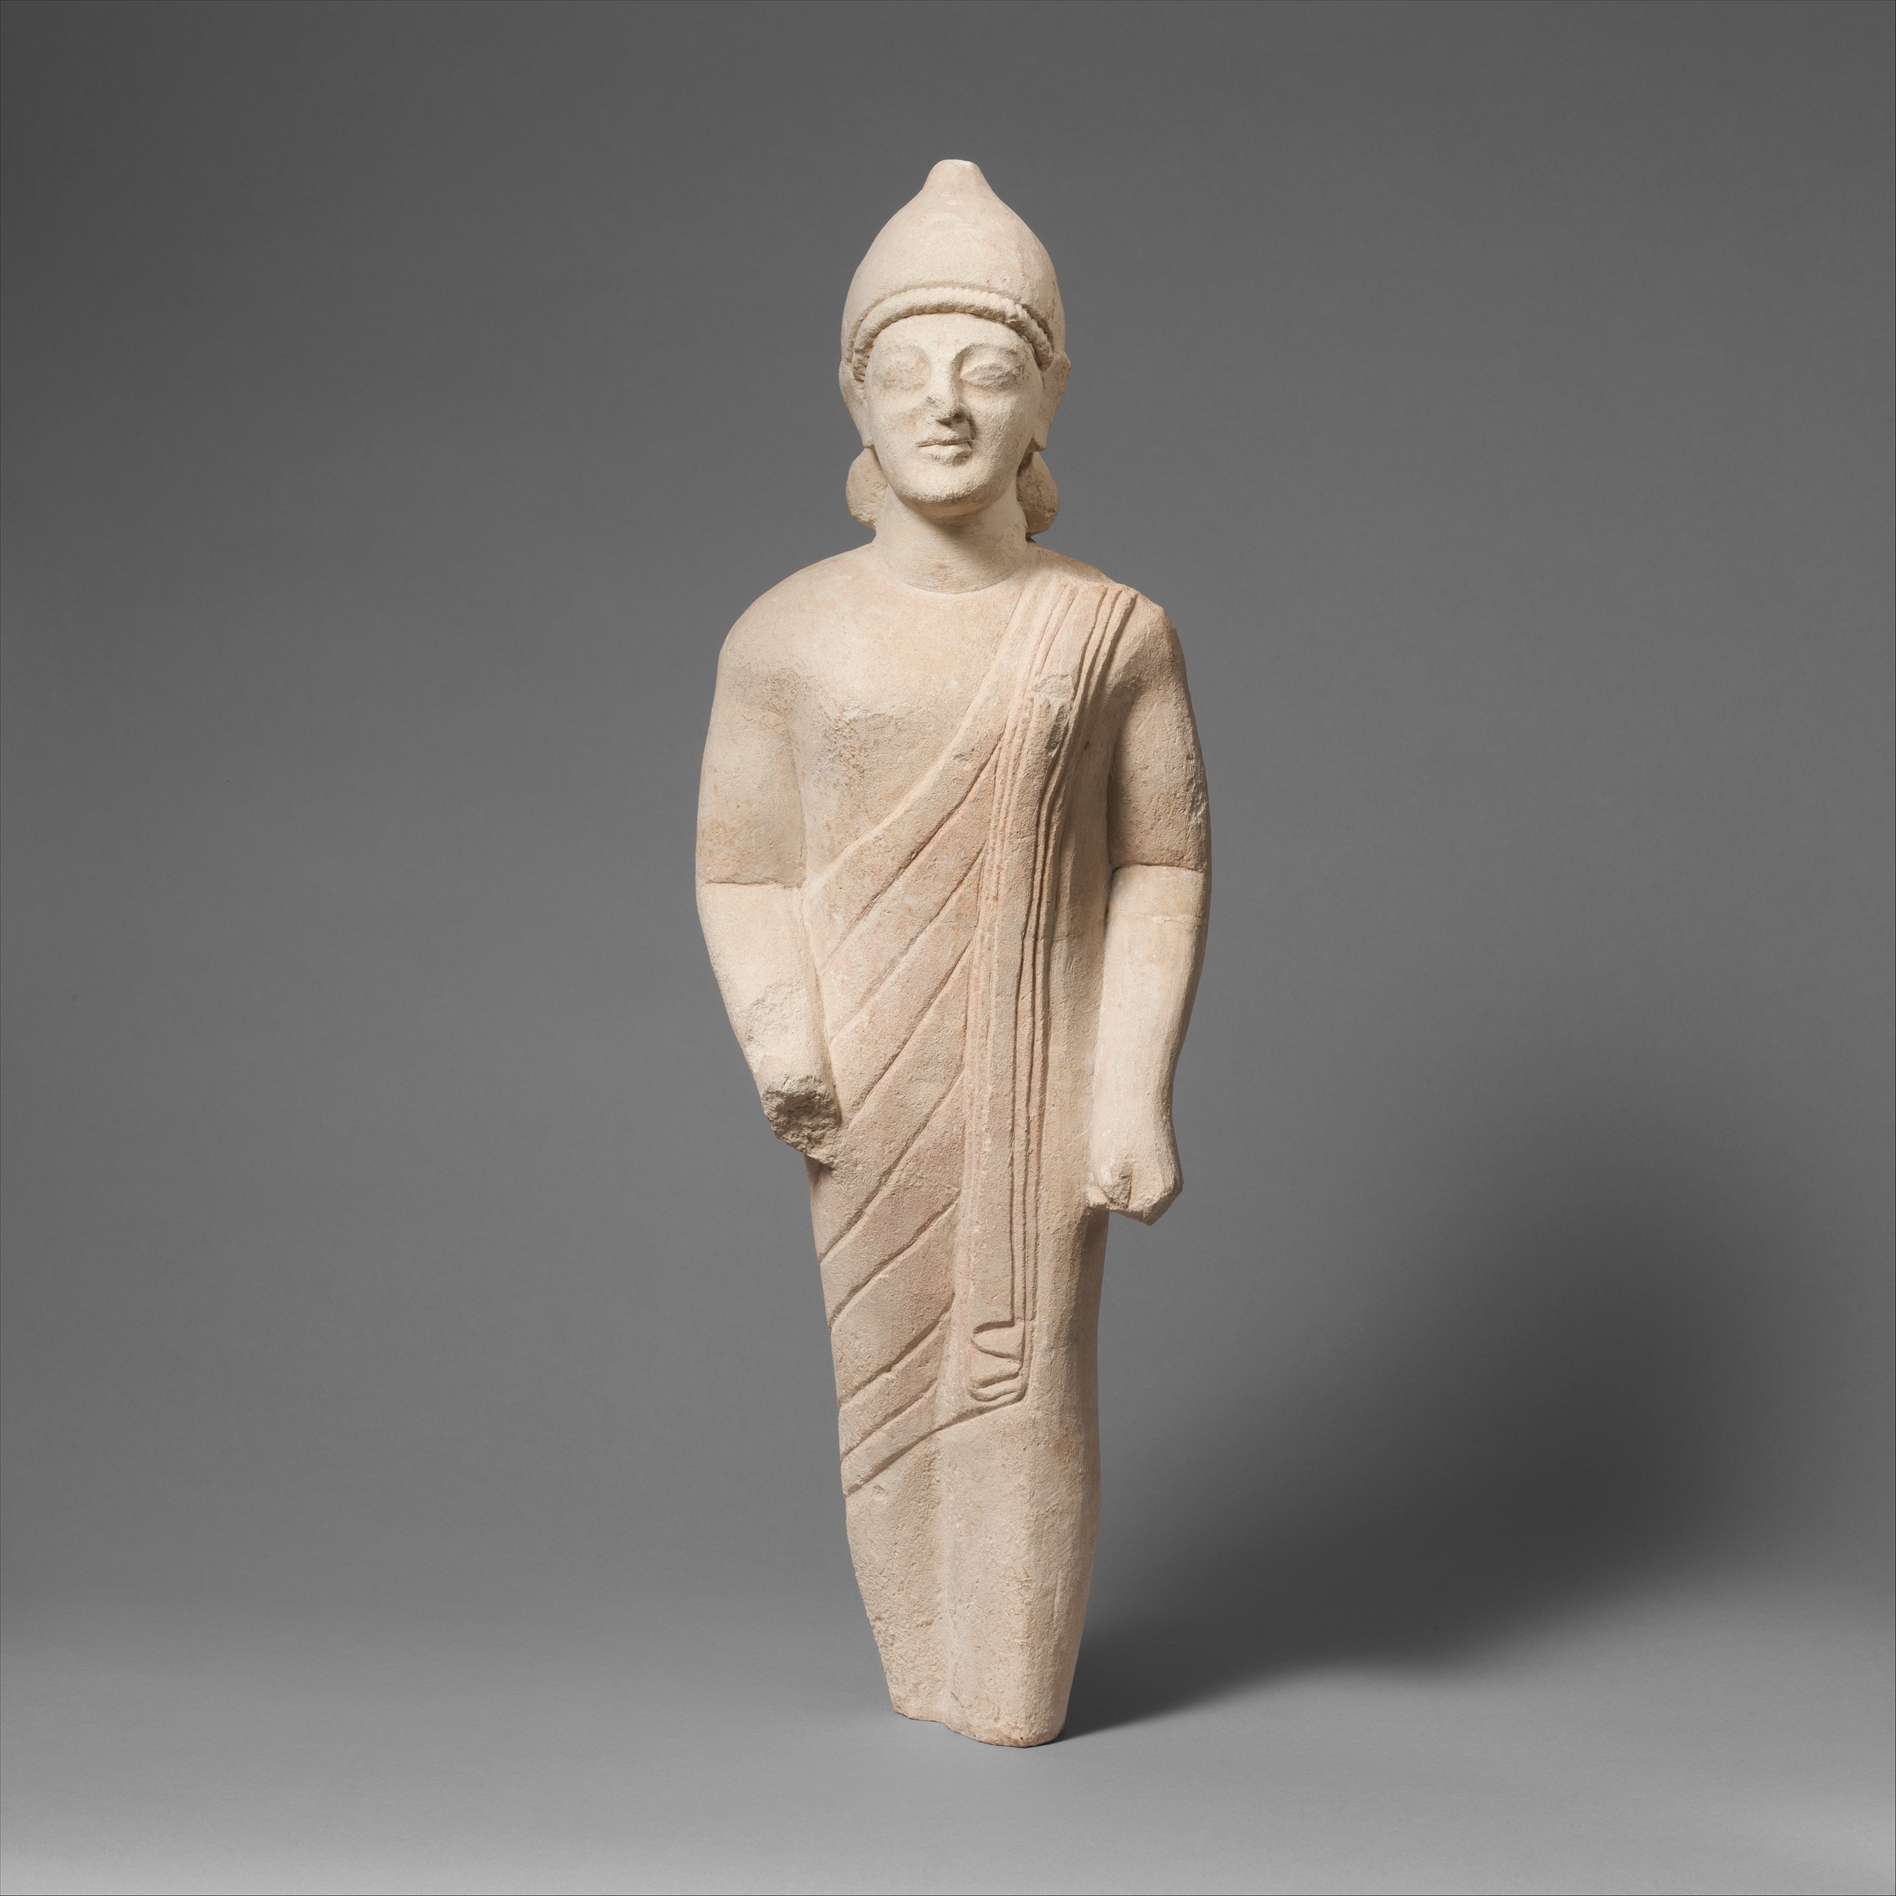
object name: statue of a votary, male, with pointed cap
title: Limestone statuette of a male votary (worshipper)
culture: cypriot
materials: limestone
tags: men